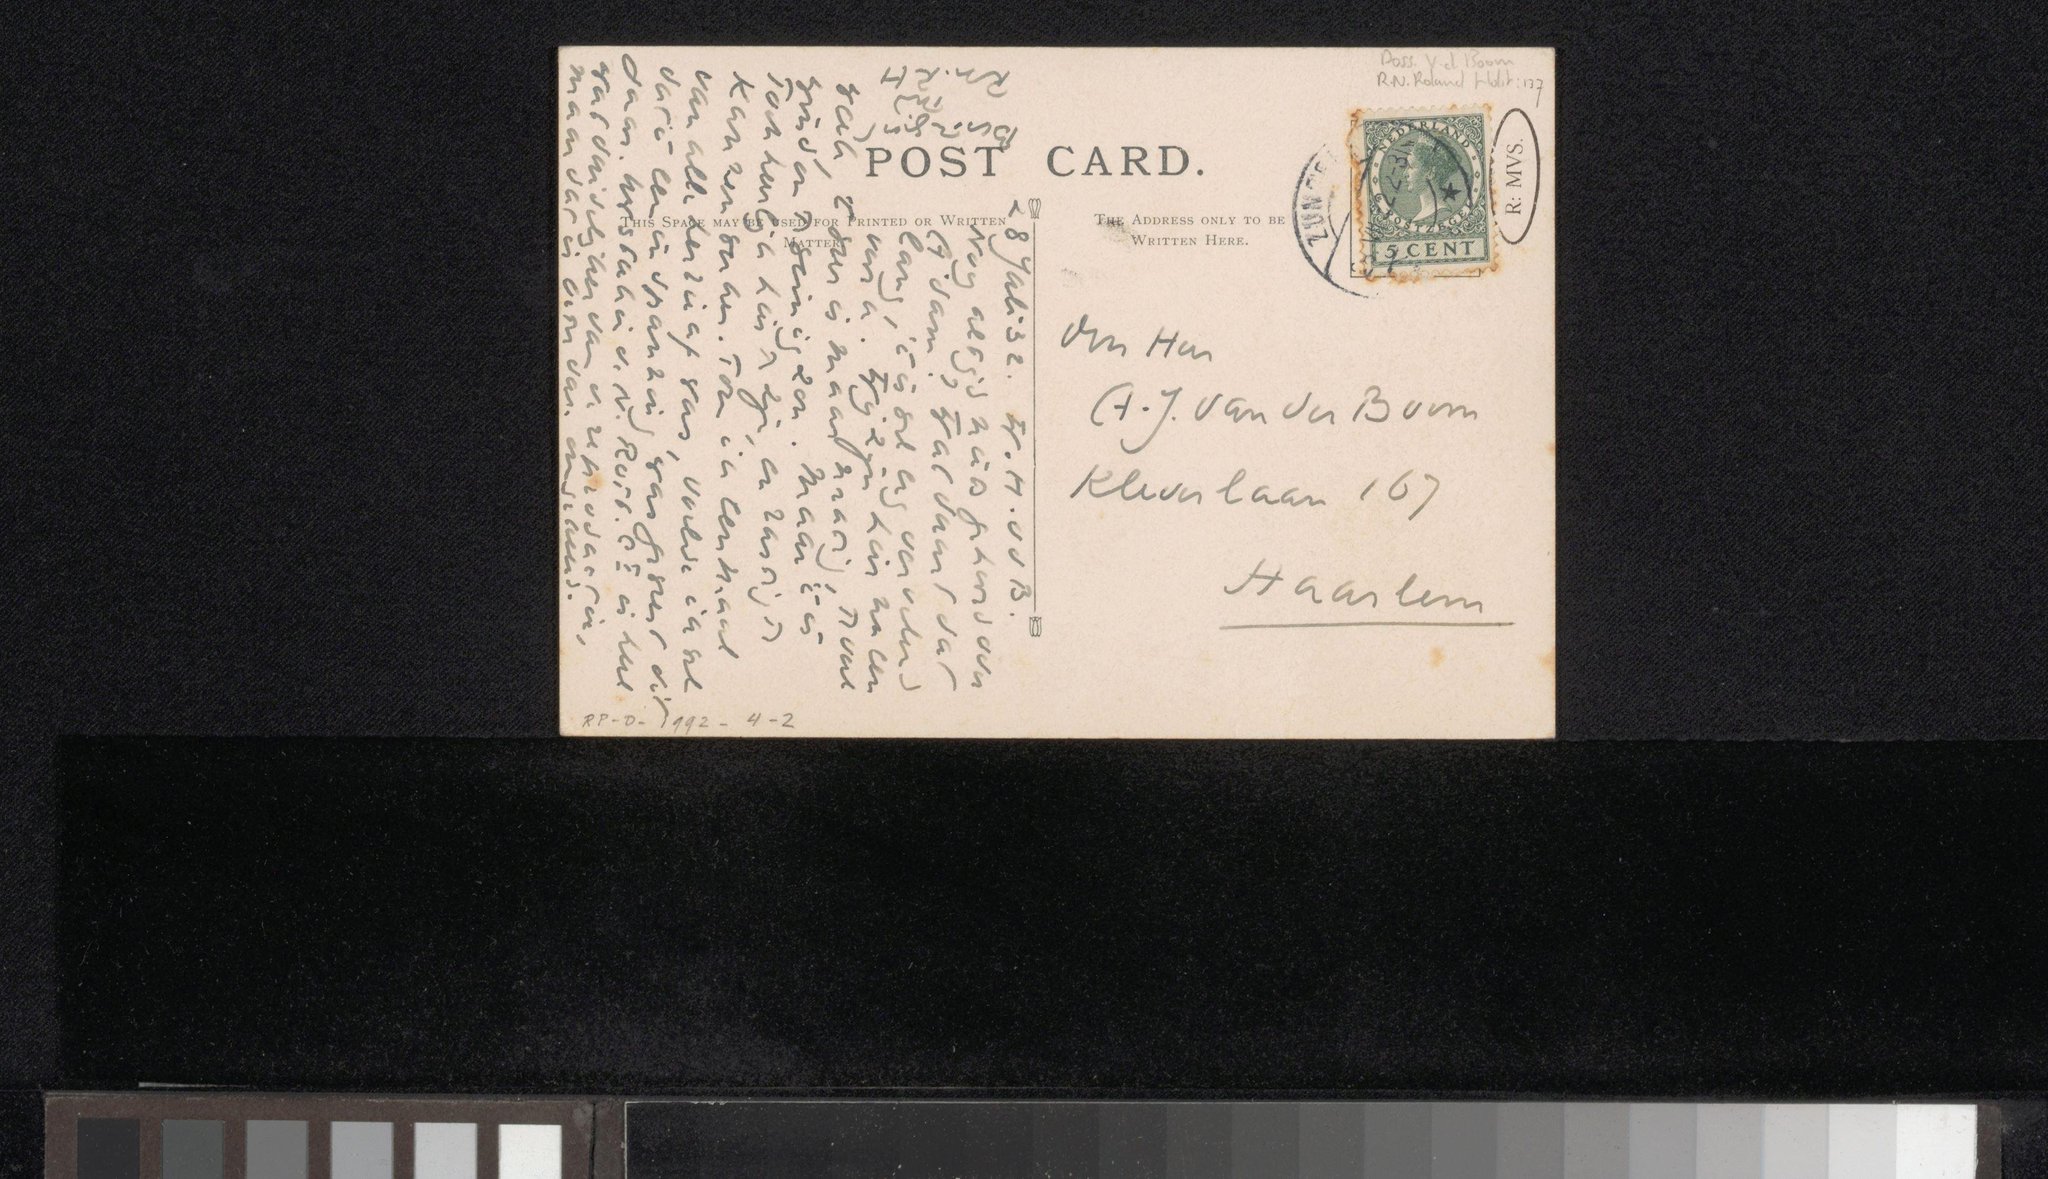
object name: ansichtkaart, prentbriefkaart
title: Prentbiefkaart aan A. van der Boom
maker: richard nicolaüs roland holst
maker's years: 1868-1938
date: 1932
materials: cardboard, ink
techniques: pen, writing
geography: zundert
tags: a. van der boom, amsterdam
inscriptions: collector's mark: Lugt L.2228a